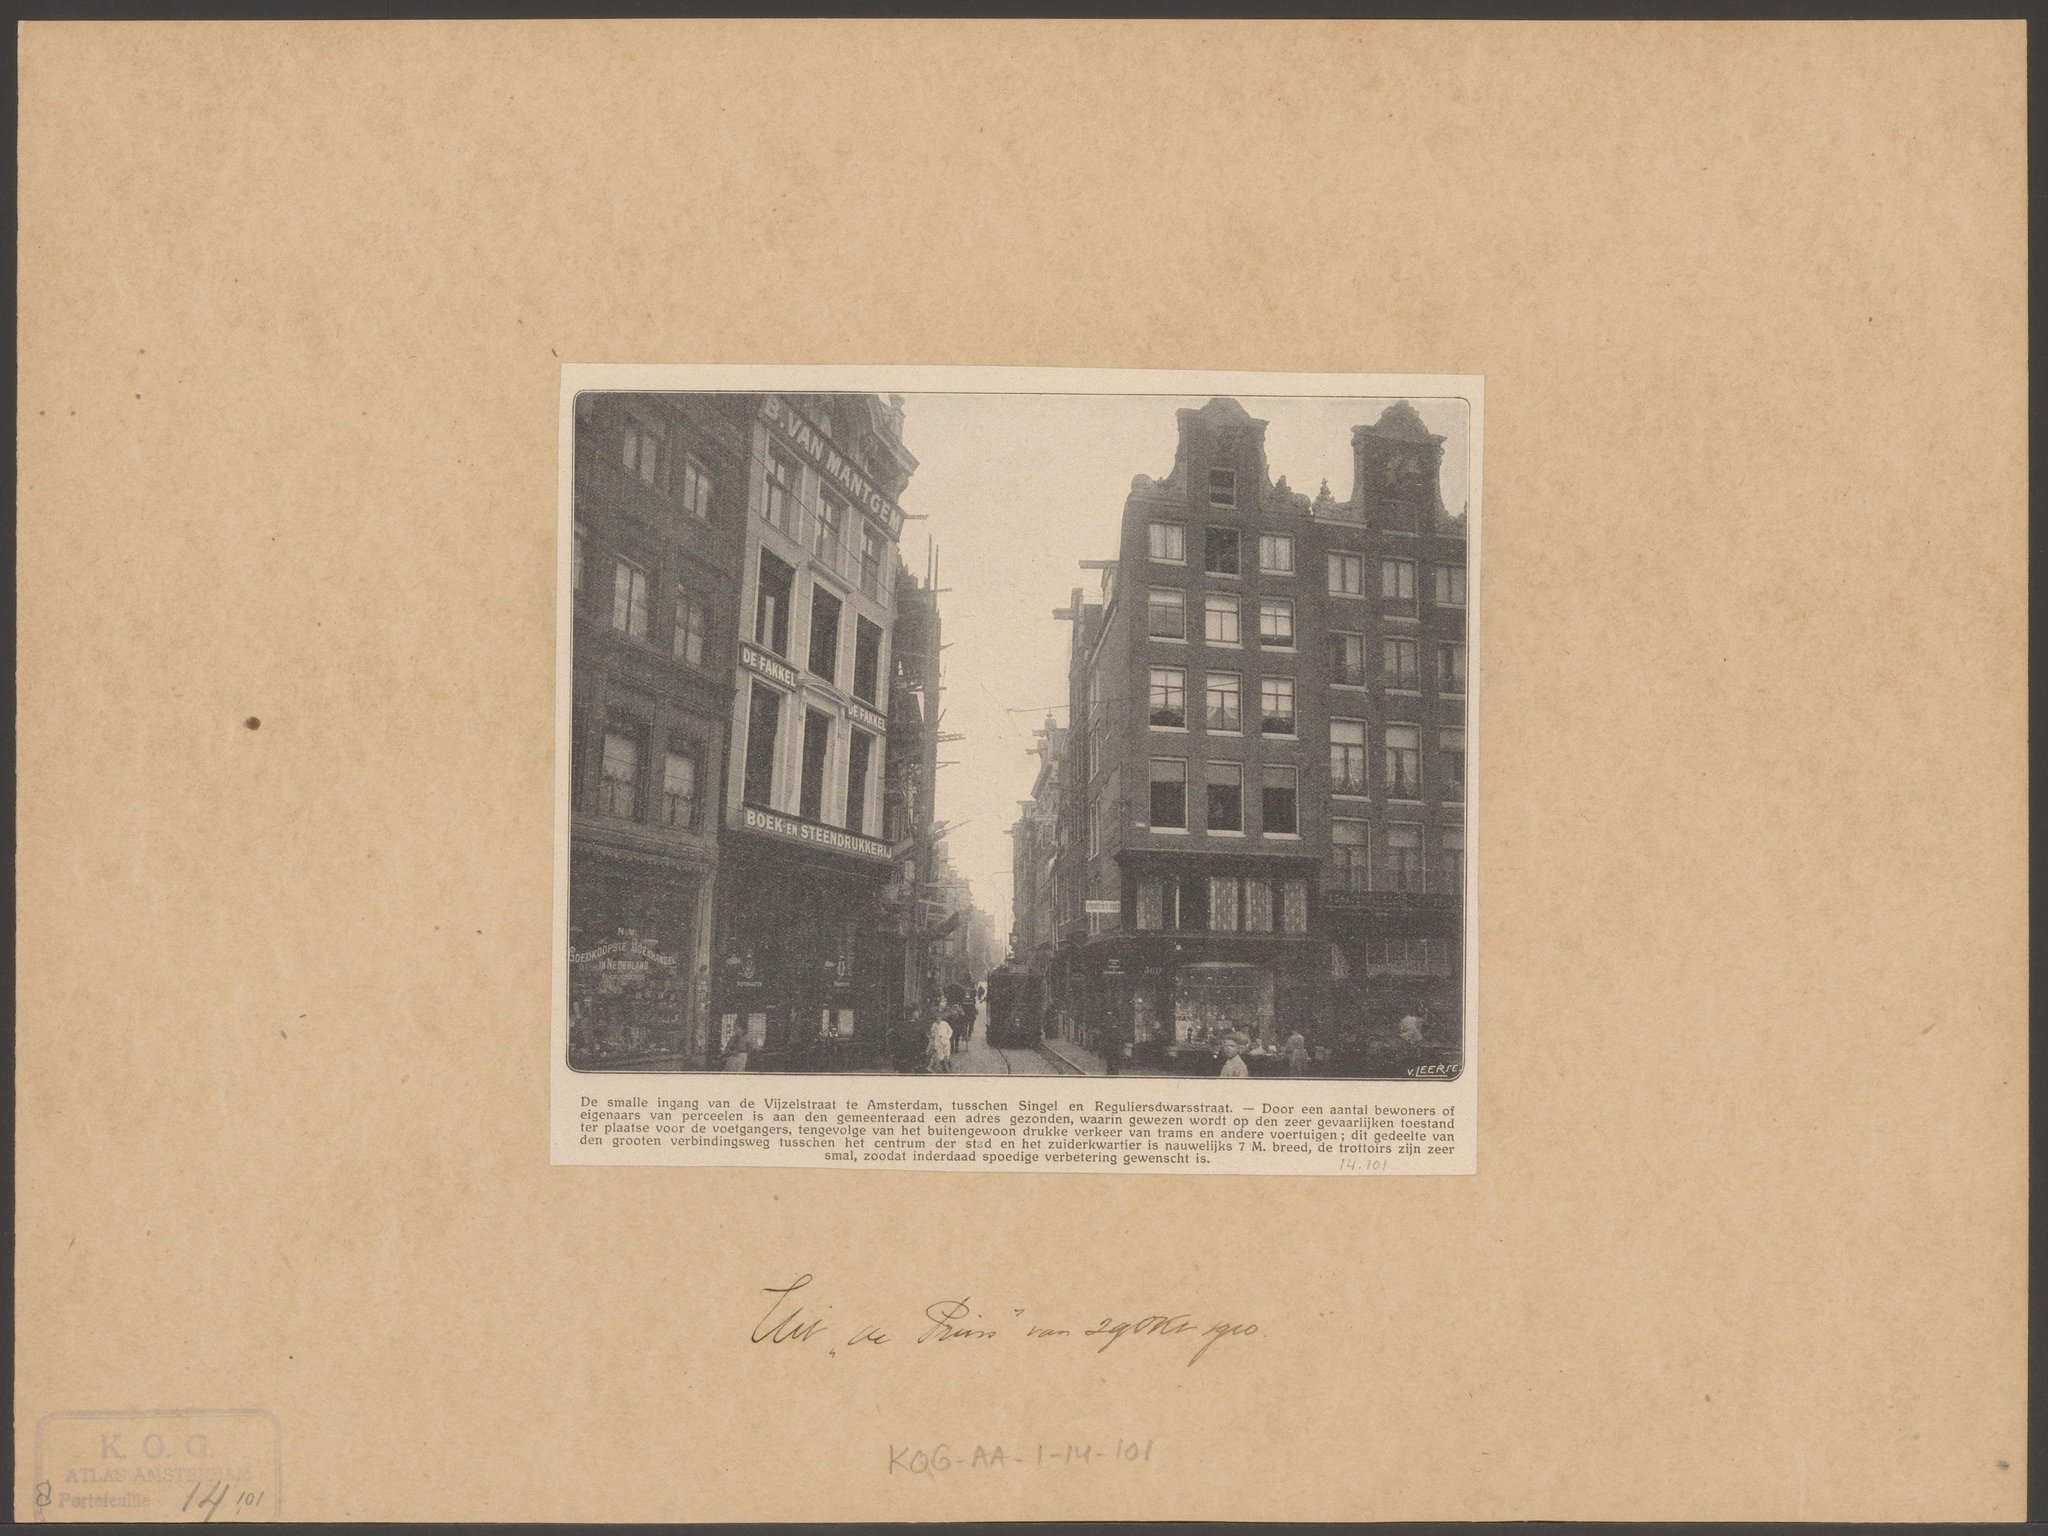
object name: photomechanical print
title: Gezicht op de Vijzelstraat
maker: Anonymous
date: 1910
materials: paper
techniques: letterpress printing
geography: amsterdam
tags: city-view in general; 'veduta', façade (of house or building), street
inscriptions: collector's mark: ‘14.101’ Lugt 1641b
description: Onderwerpsrubriek binnen de Atlas Amsterdam: Voorburgwal (O.Z.), Voorweg, Vijgendam, Vijzelstraat.